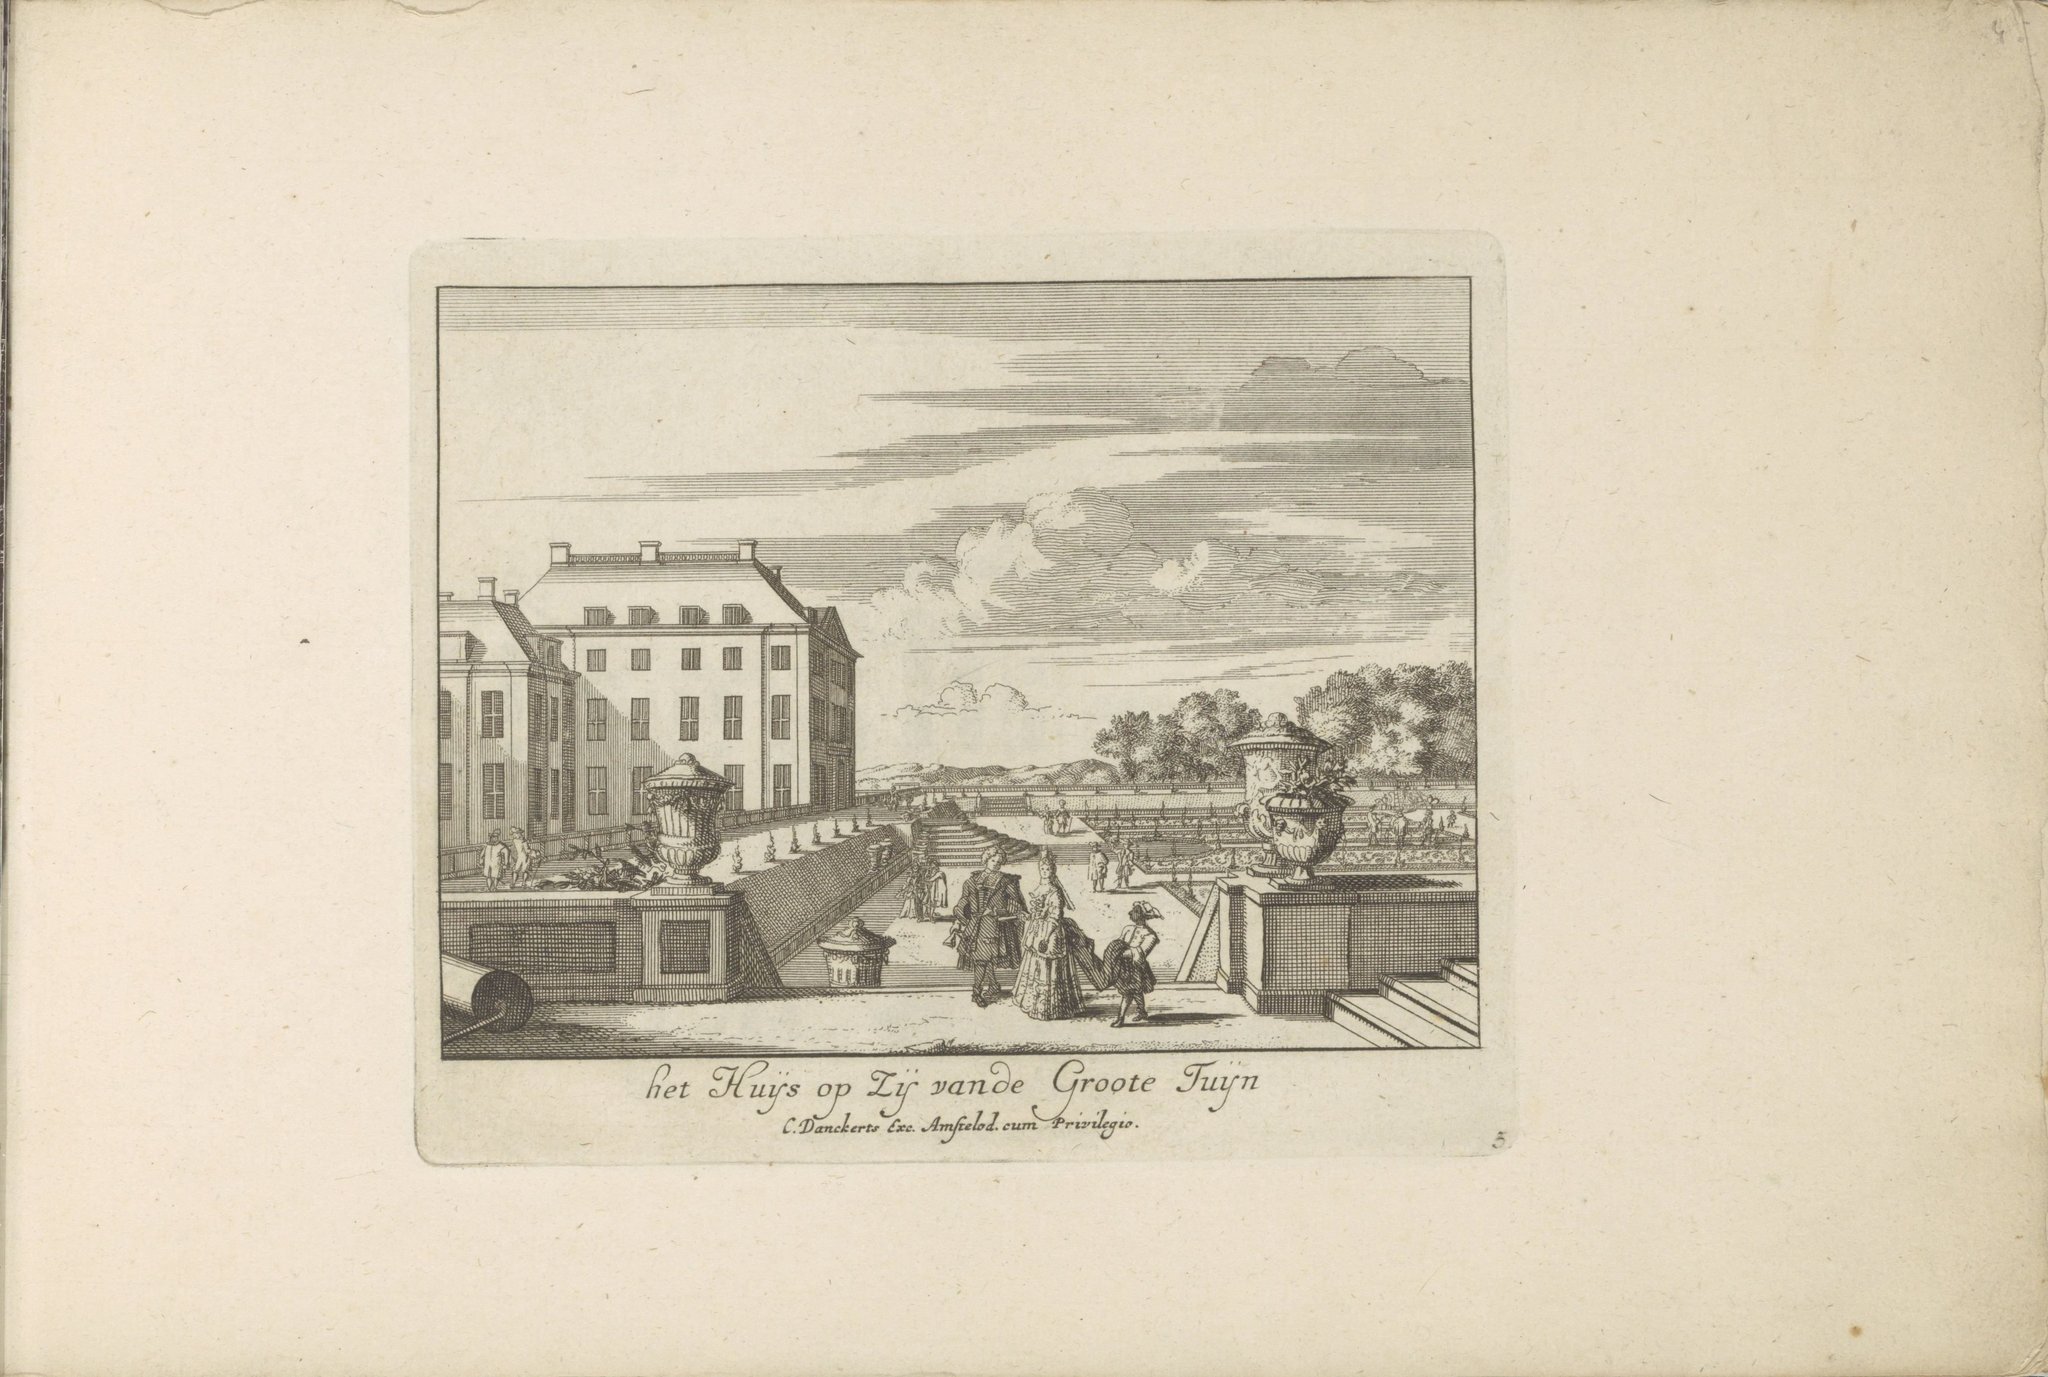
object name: album leaf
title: Het Huijs op Zij vande Groote Tuijn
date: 1696-1718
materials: paper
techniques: etching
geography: amsterdam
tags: palace, french or architectonic garden; formal garden, exterior ~ representation of a building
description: Zijaanzicht van Paleis Het Loo aan de kant van de tuinen. Op de voorgrond een elegant paar en een dienaar. Prent maakt deel uit van een album.